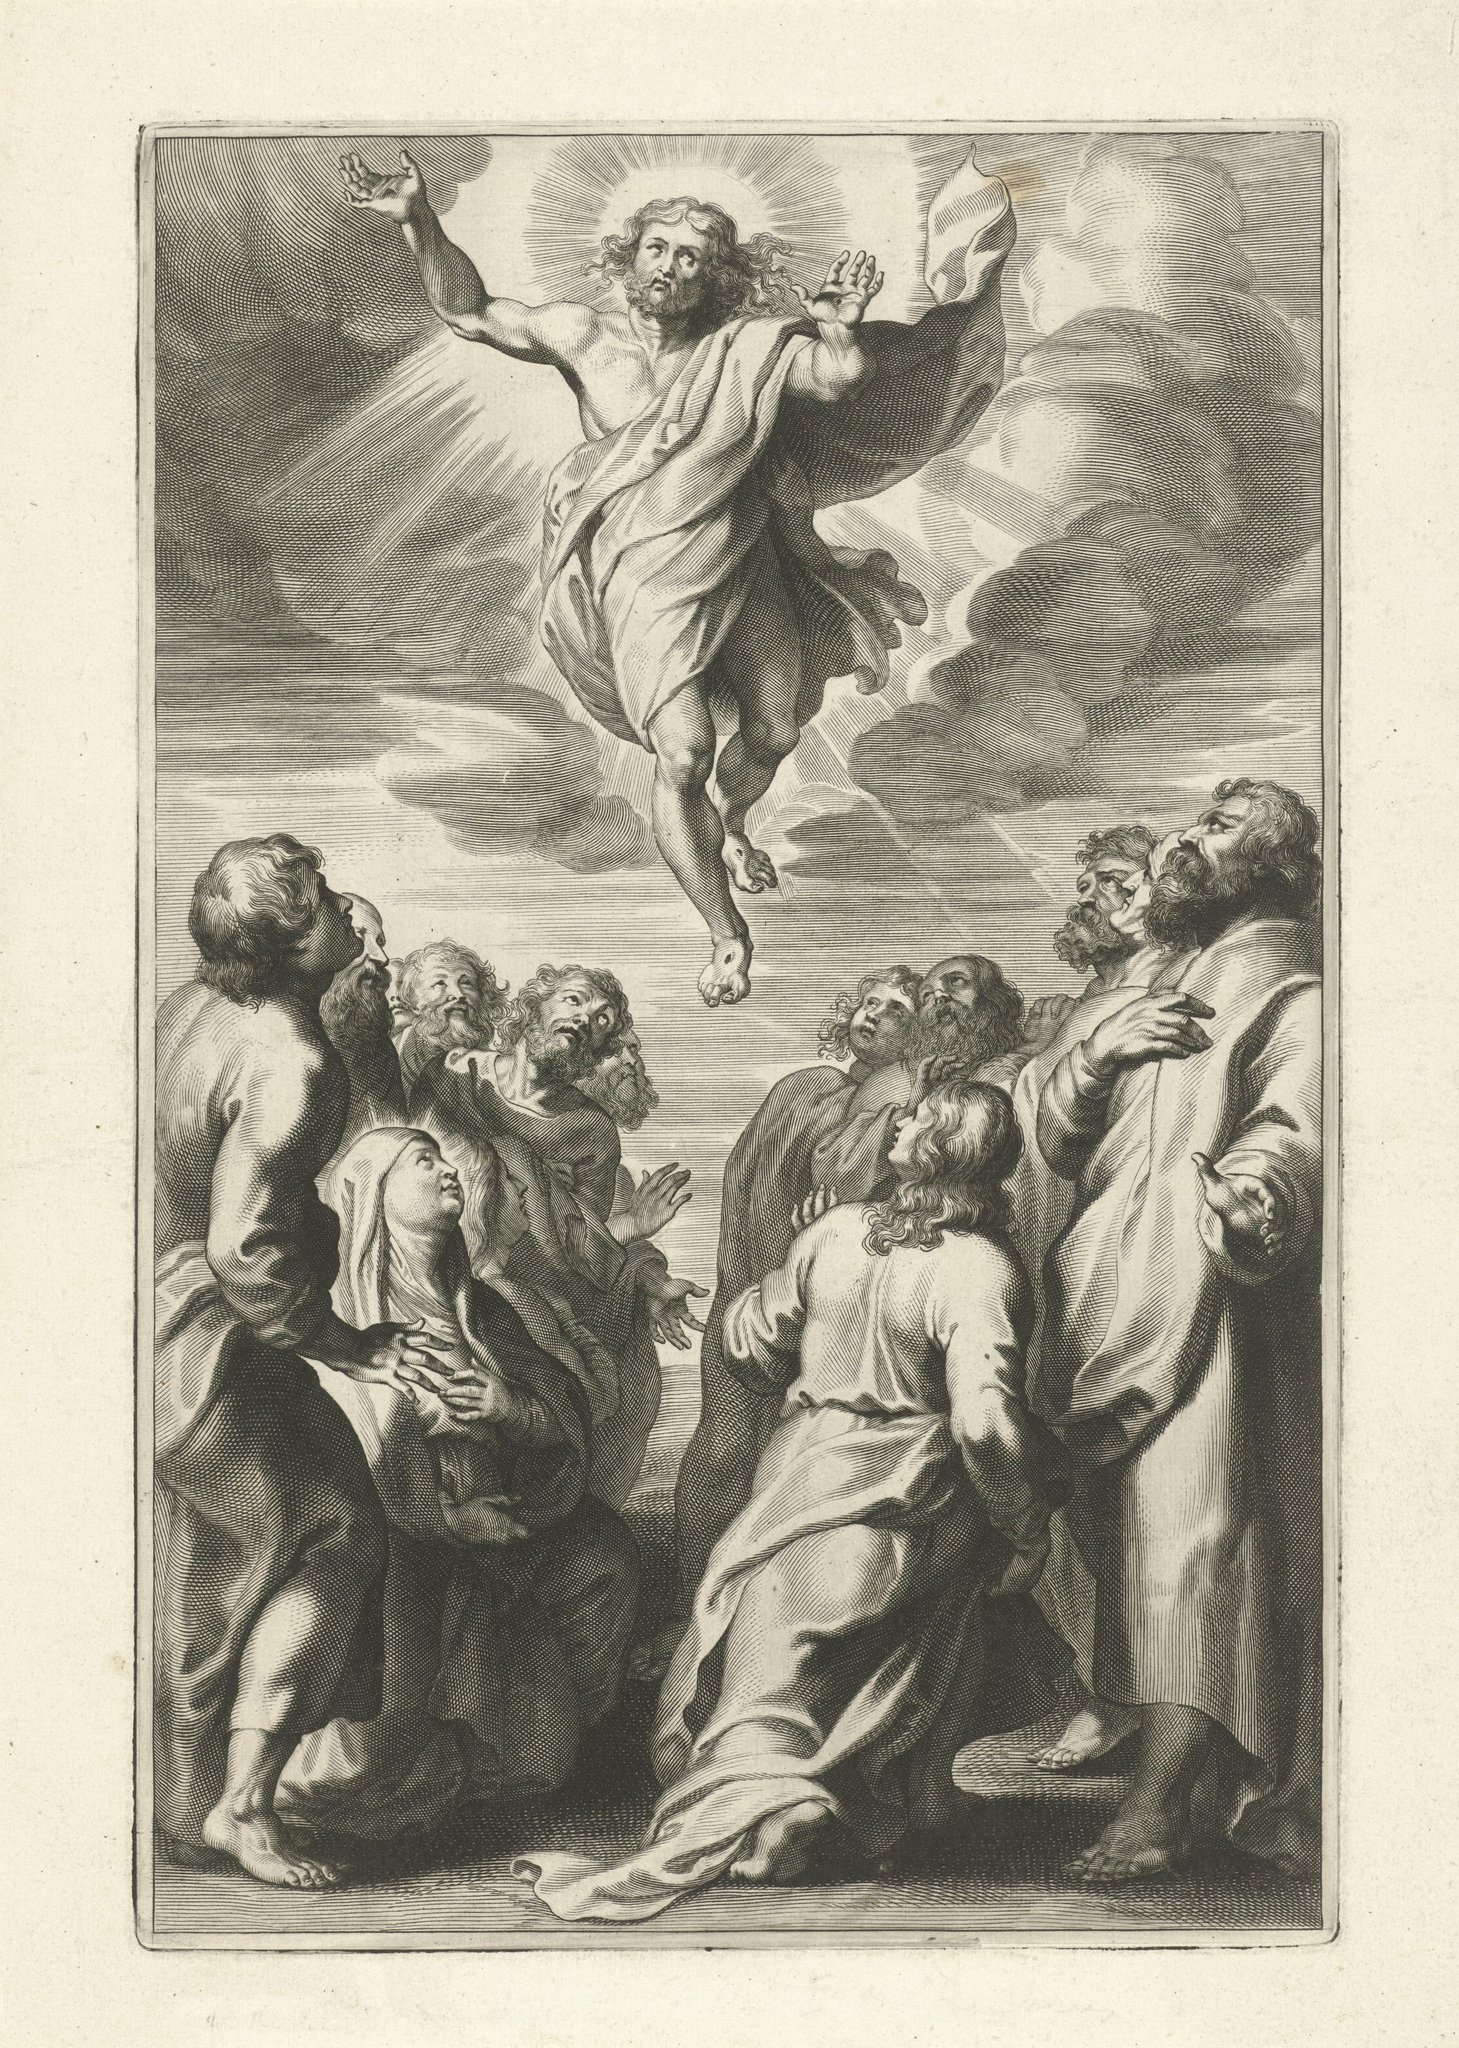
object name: print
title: Hemelvaart van Christus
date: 1614-1683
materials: paper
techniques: engraving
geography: antwerp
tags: the ascension (christ surrounded by radiant light or in a mandorla)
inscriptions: collector's mark: Lugt 240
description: Mogelijk illustratie voor Breviarium Romanum ex decreto sacrosancti concilii, Antwerpen (verschillende editities).